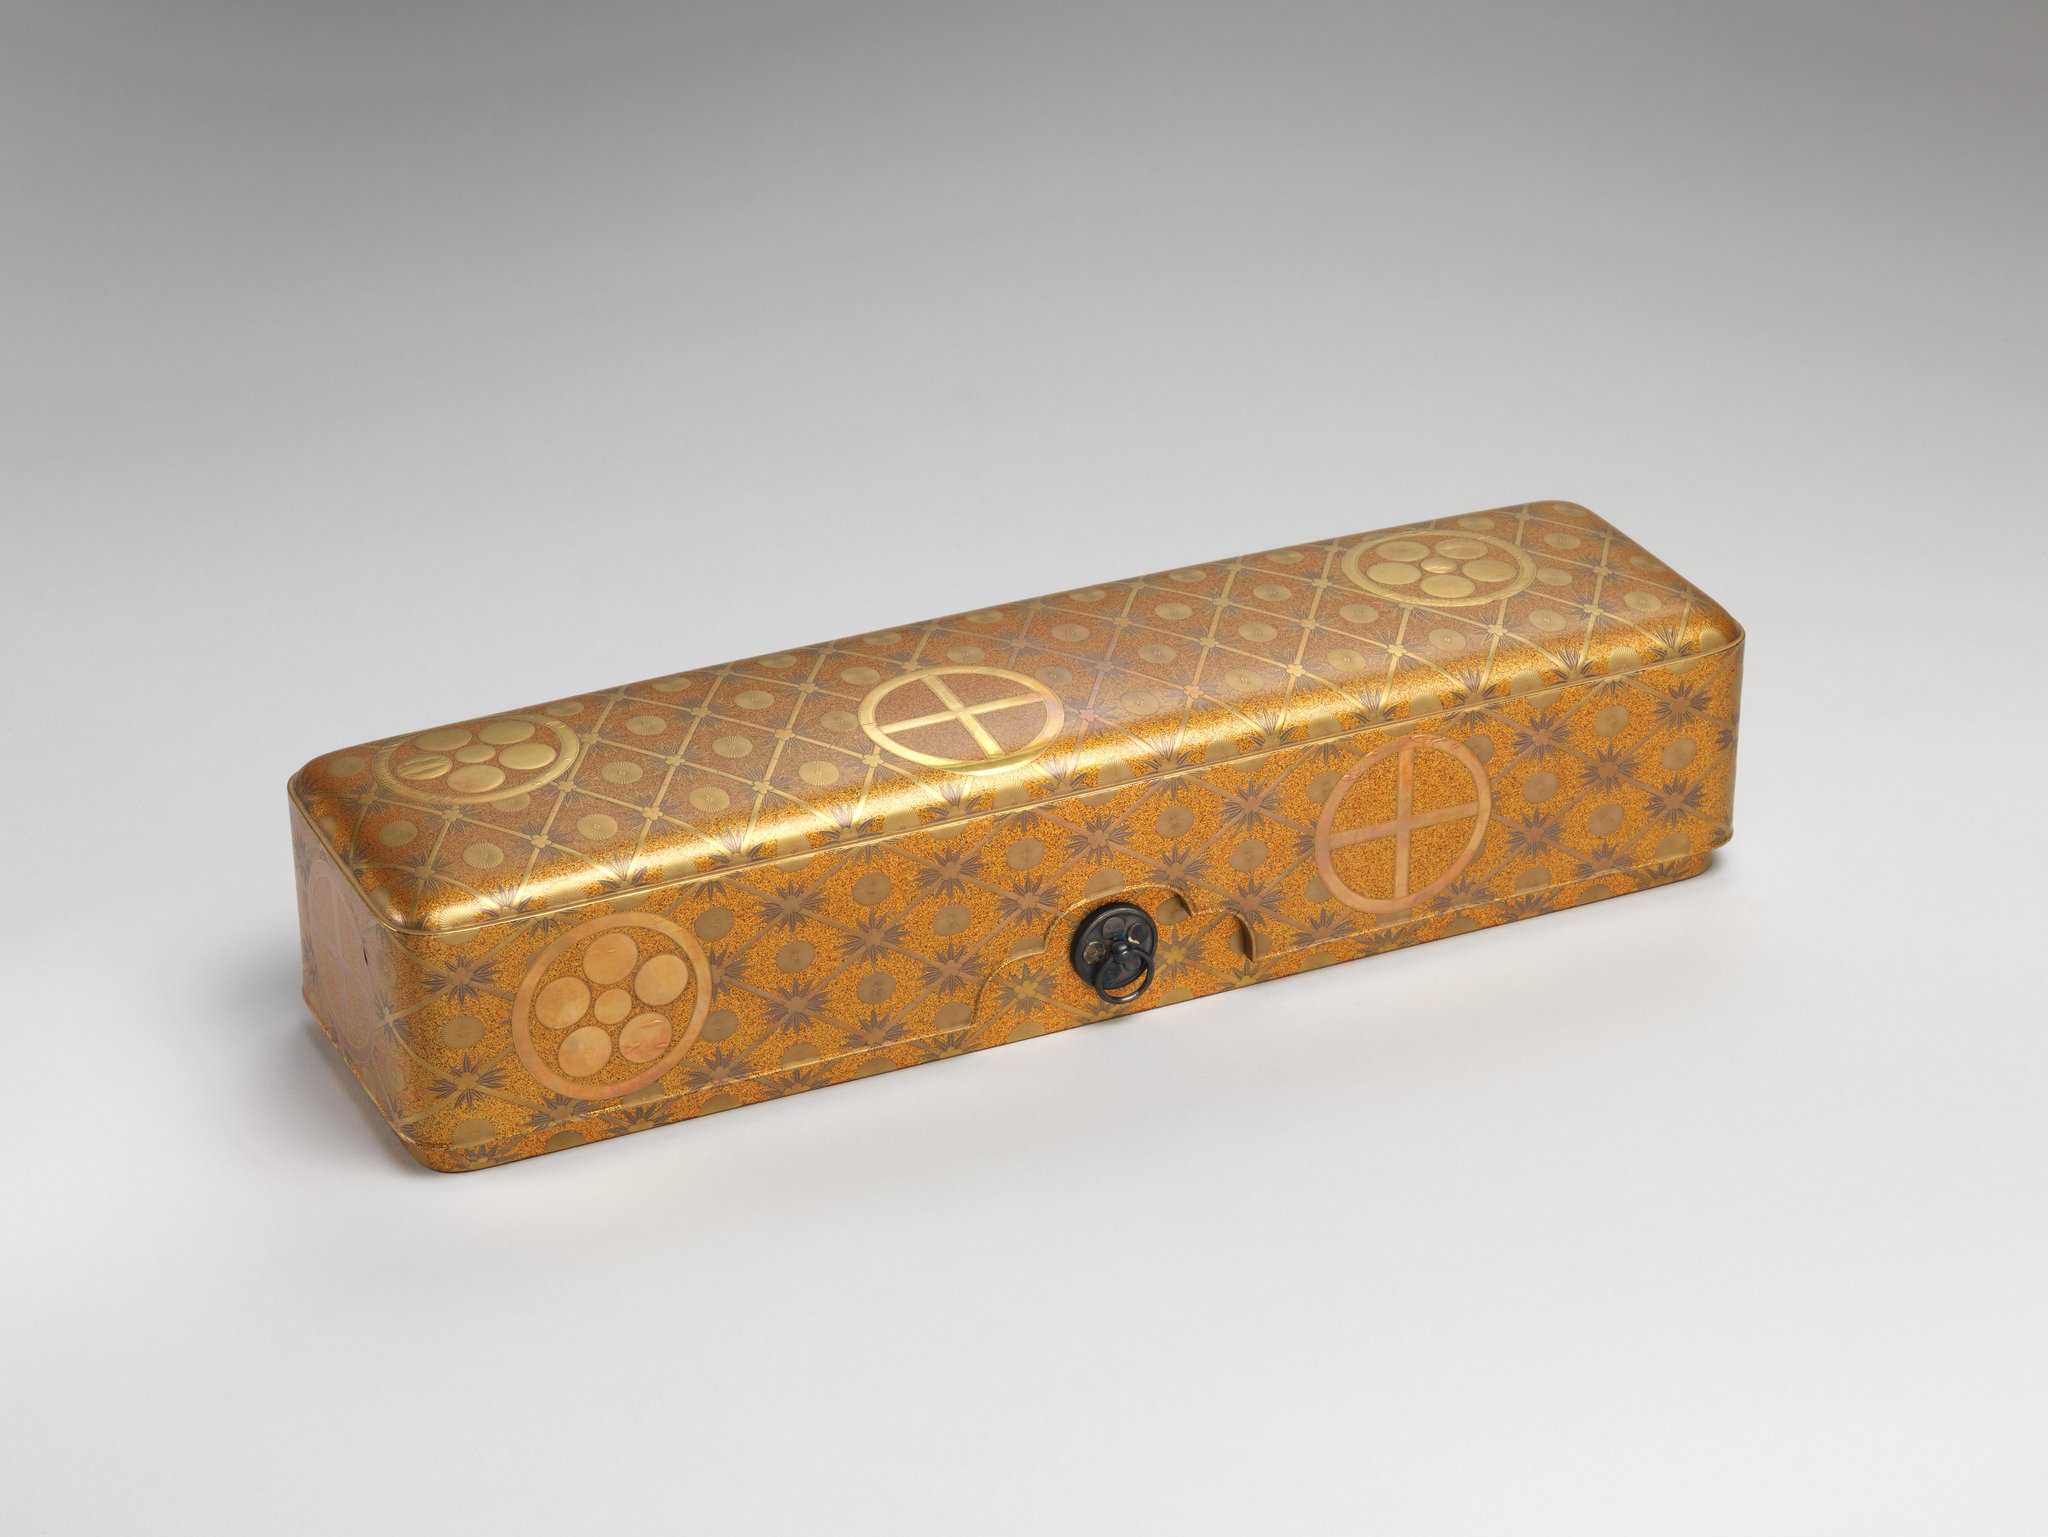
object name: letter box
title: Letter Box with Pine, Bamboo, Plum Blossom, and Family Crests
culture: japanese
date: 1801-1900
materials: gold, gold foil, silver, wood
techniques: cutting, hiramakie, lacquer